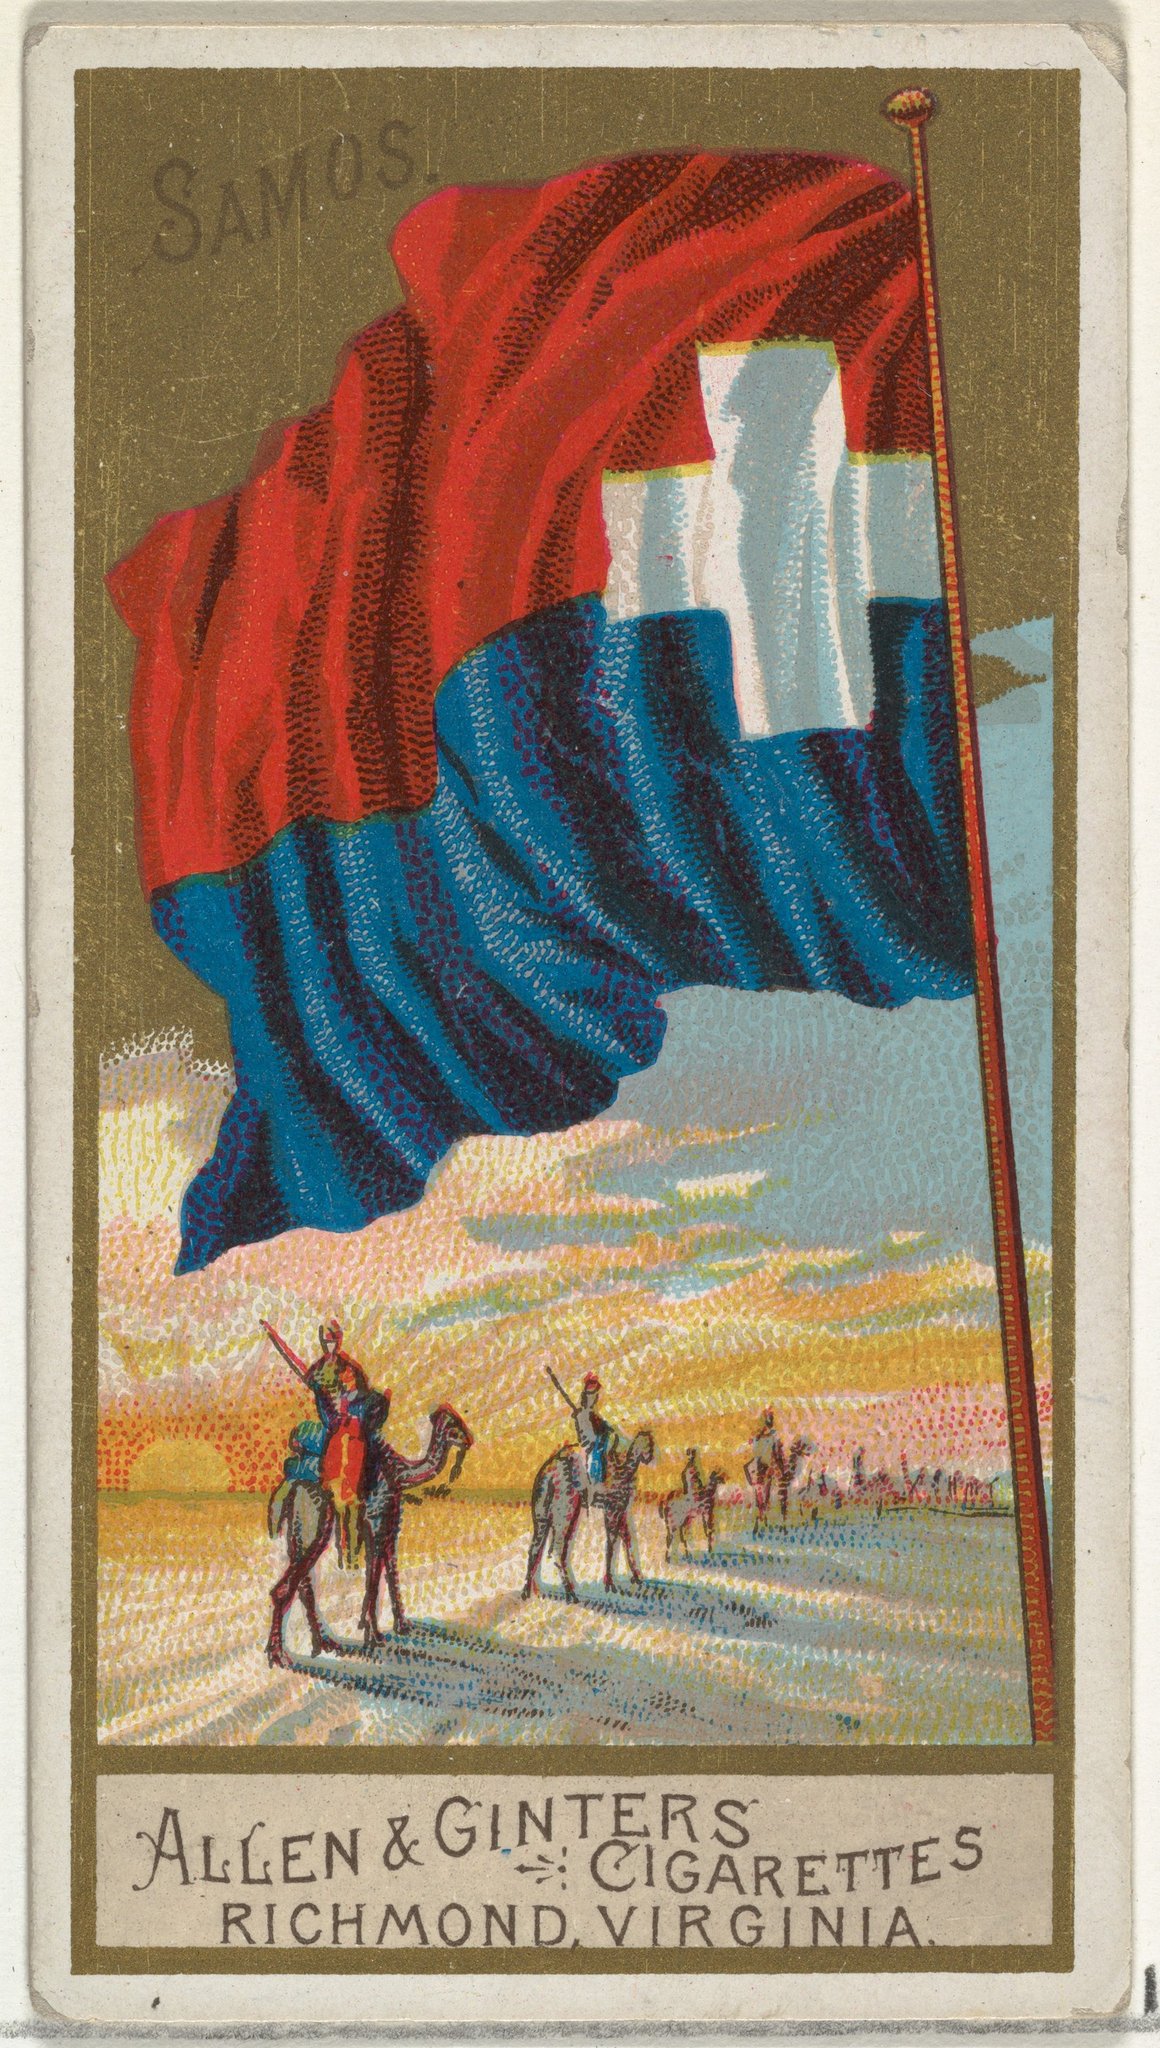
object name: print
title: Samos, from Flags of All Nations, Series 2 (N10) for Allen & Ginter Cigarettes Brands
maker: allen & ginter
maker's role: publisher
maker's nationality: american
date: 1890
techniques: color lithograph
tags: flags